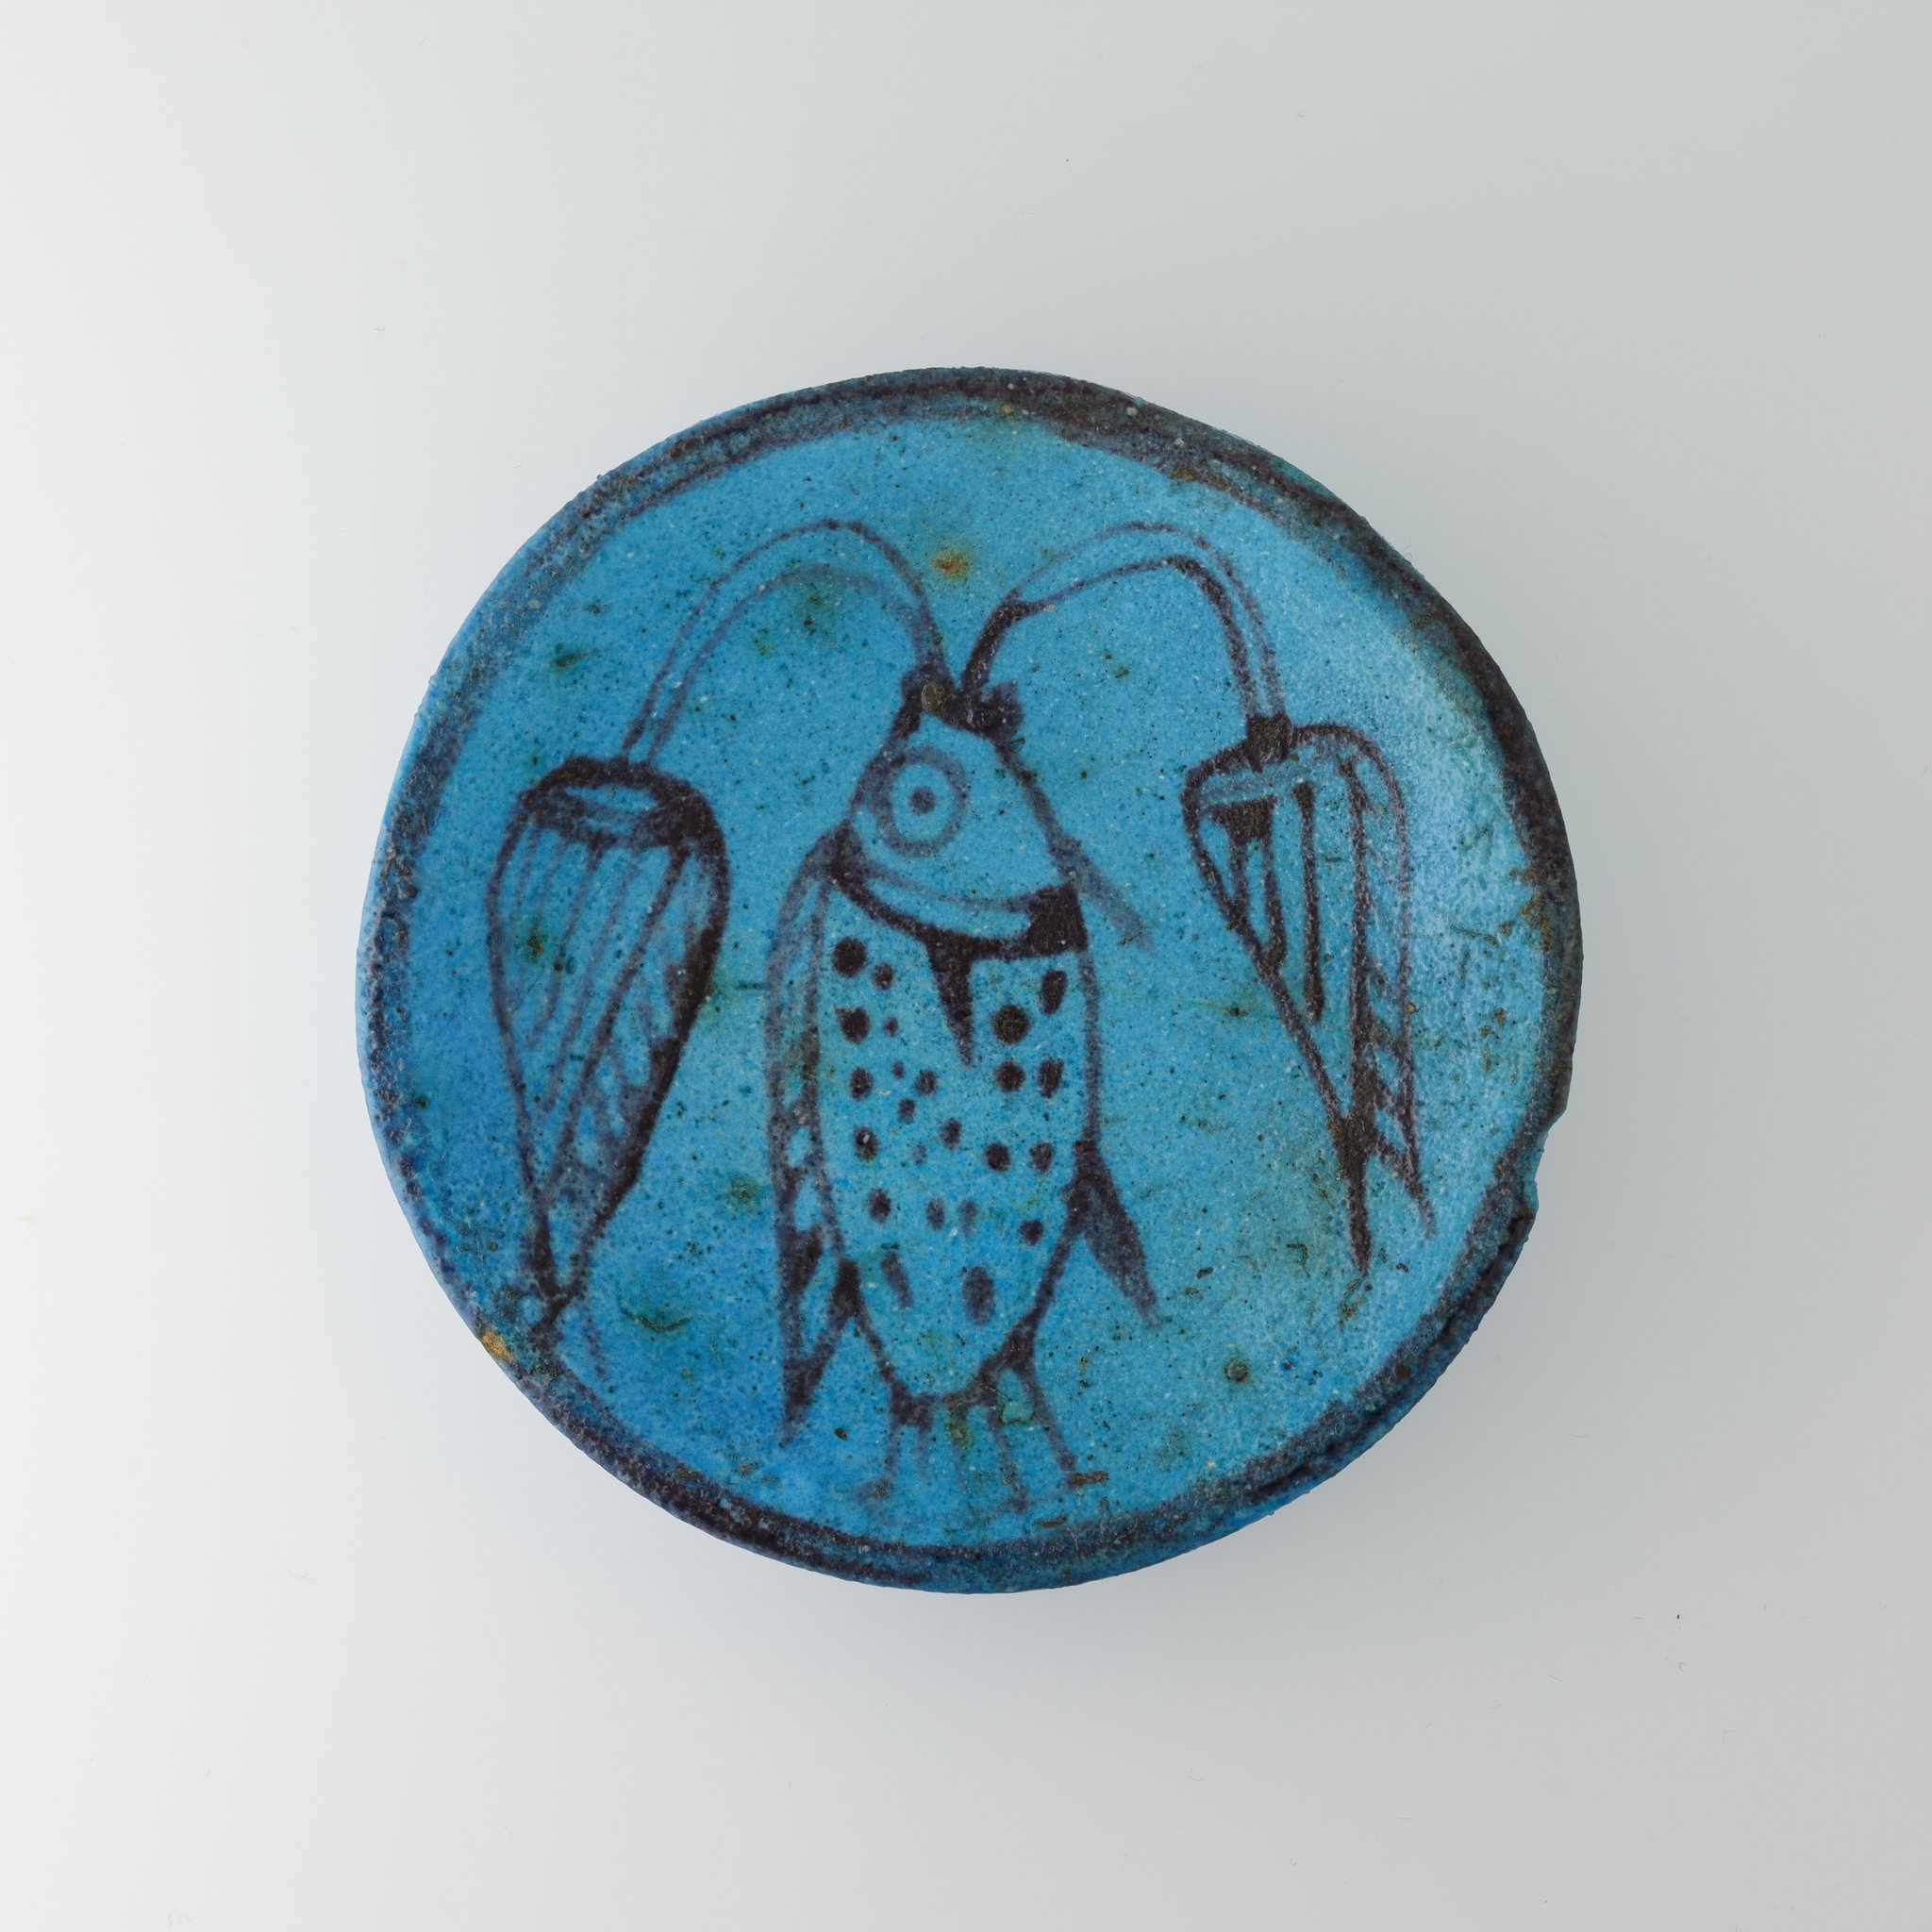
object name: bowl with fish and lotus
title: Bowl with fish and lotuses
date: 1550-1295 BCE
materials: faience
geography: egypt